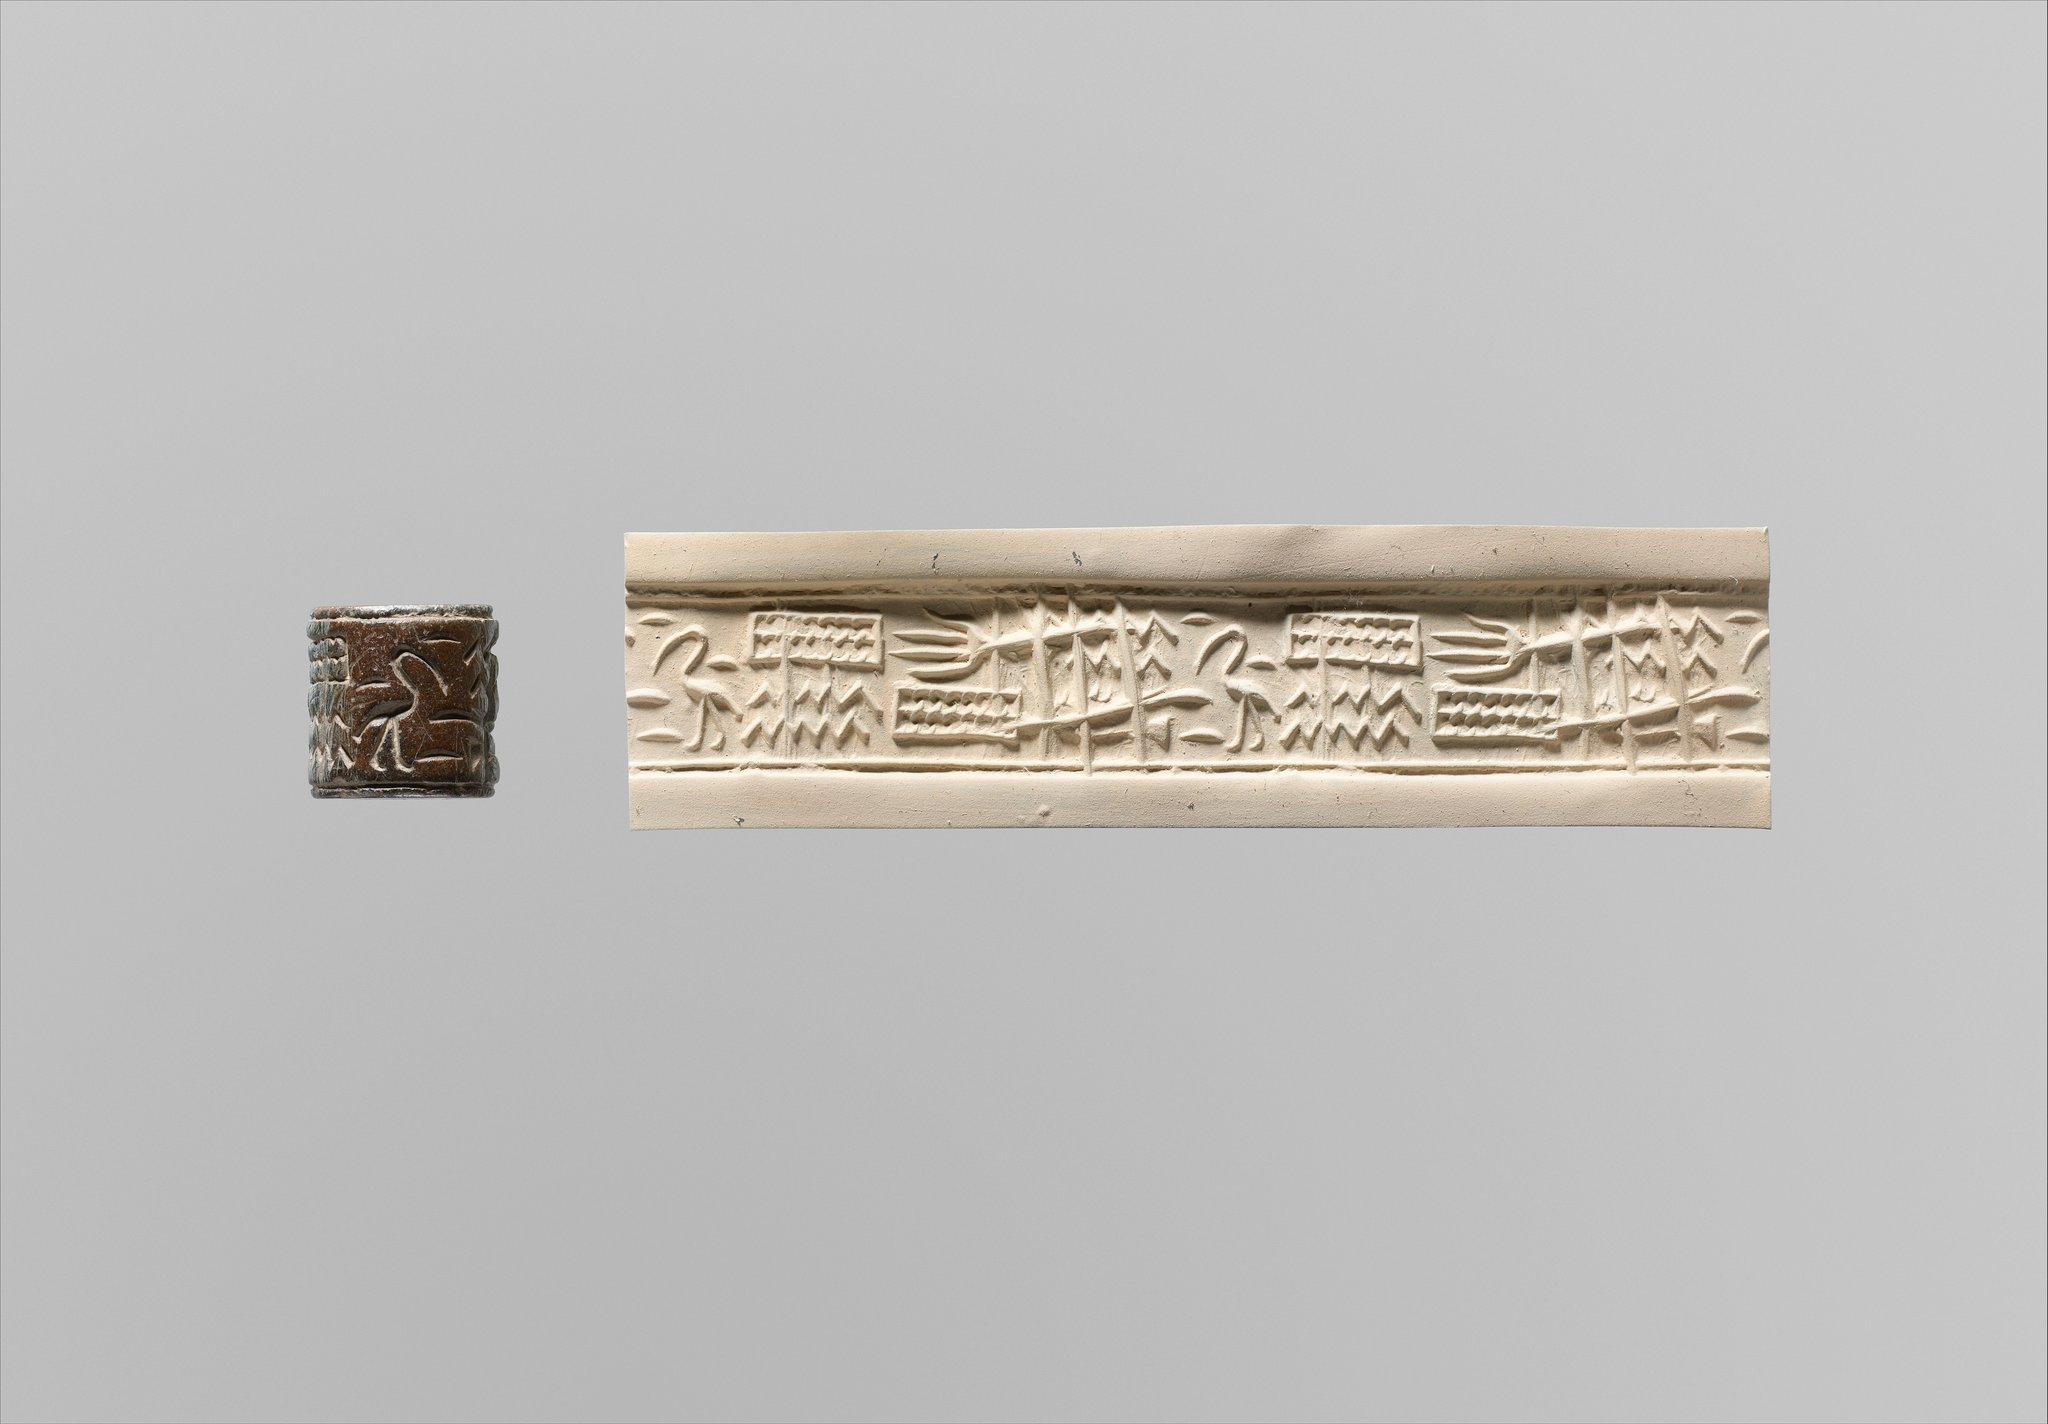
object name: cylinder seal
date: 3100-2650 BCE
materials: stone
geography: egypt